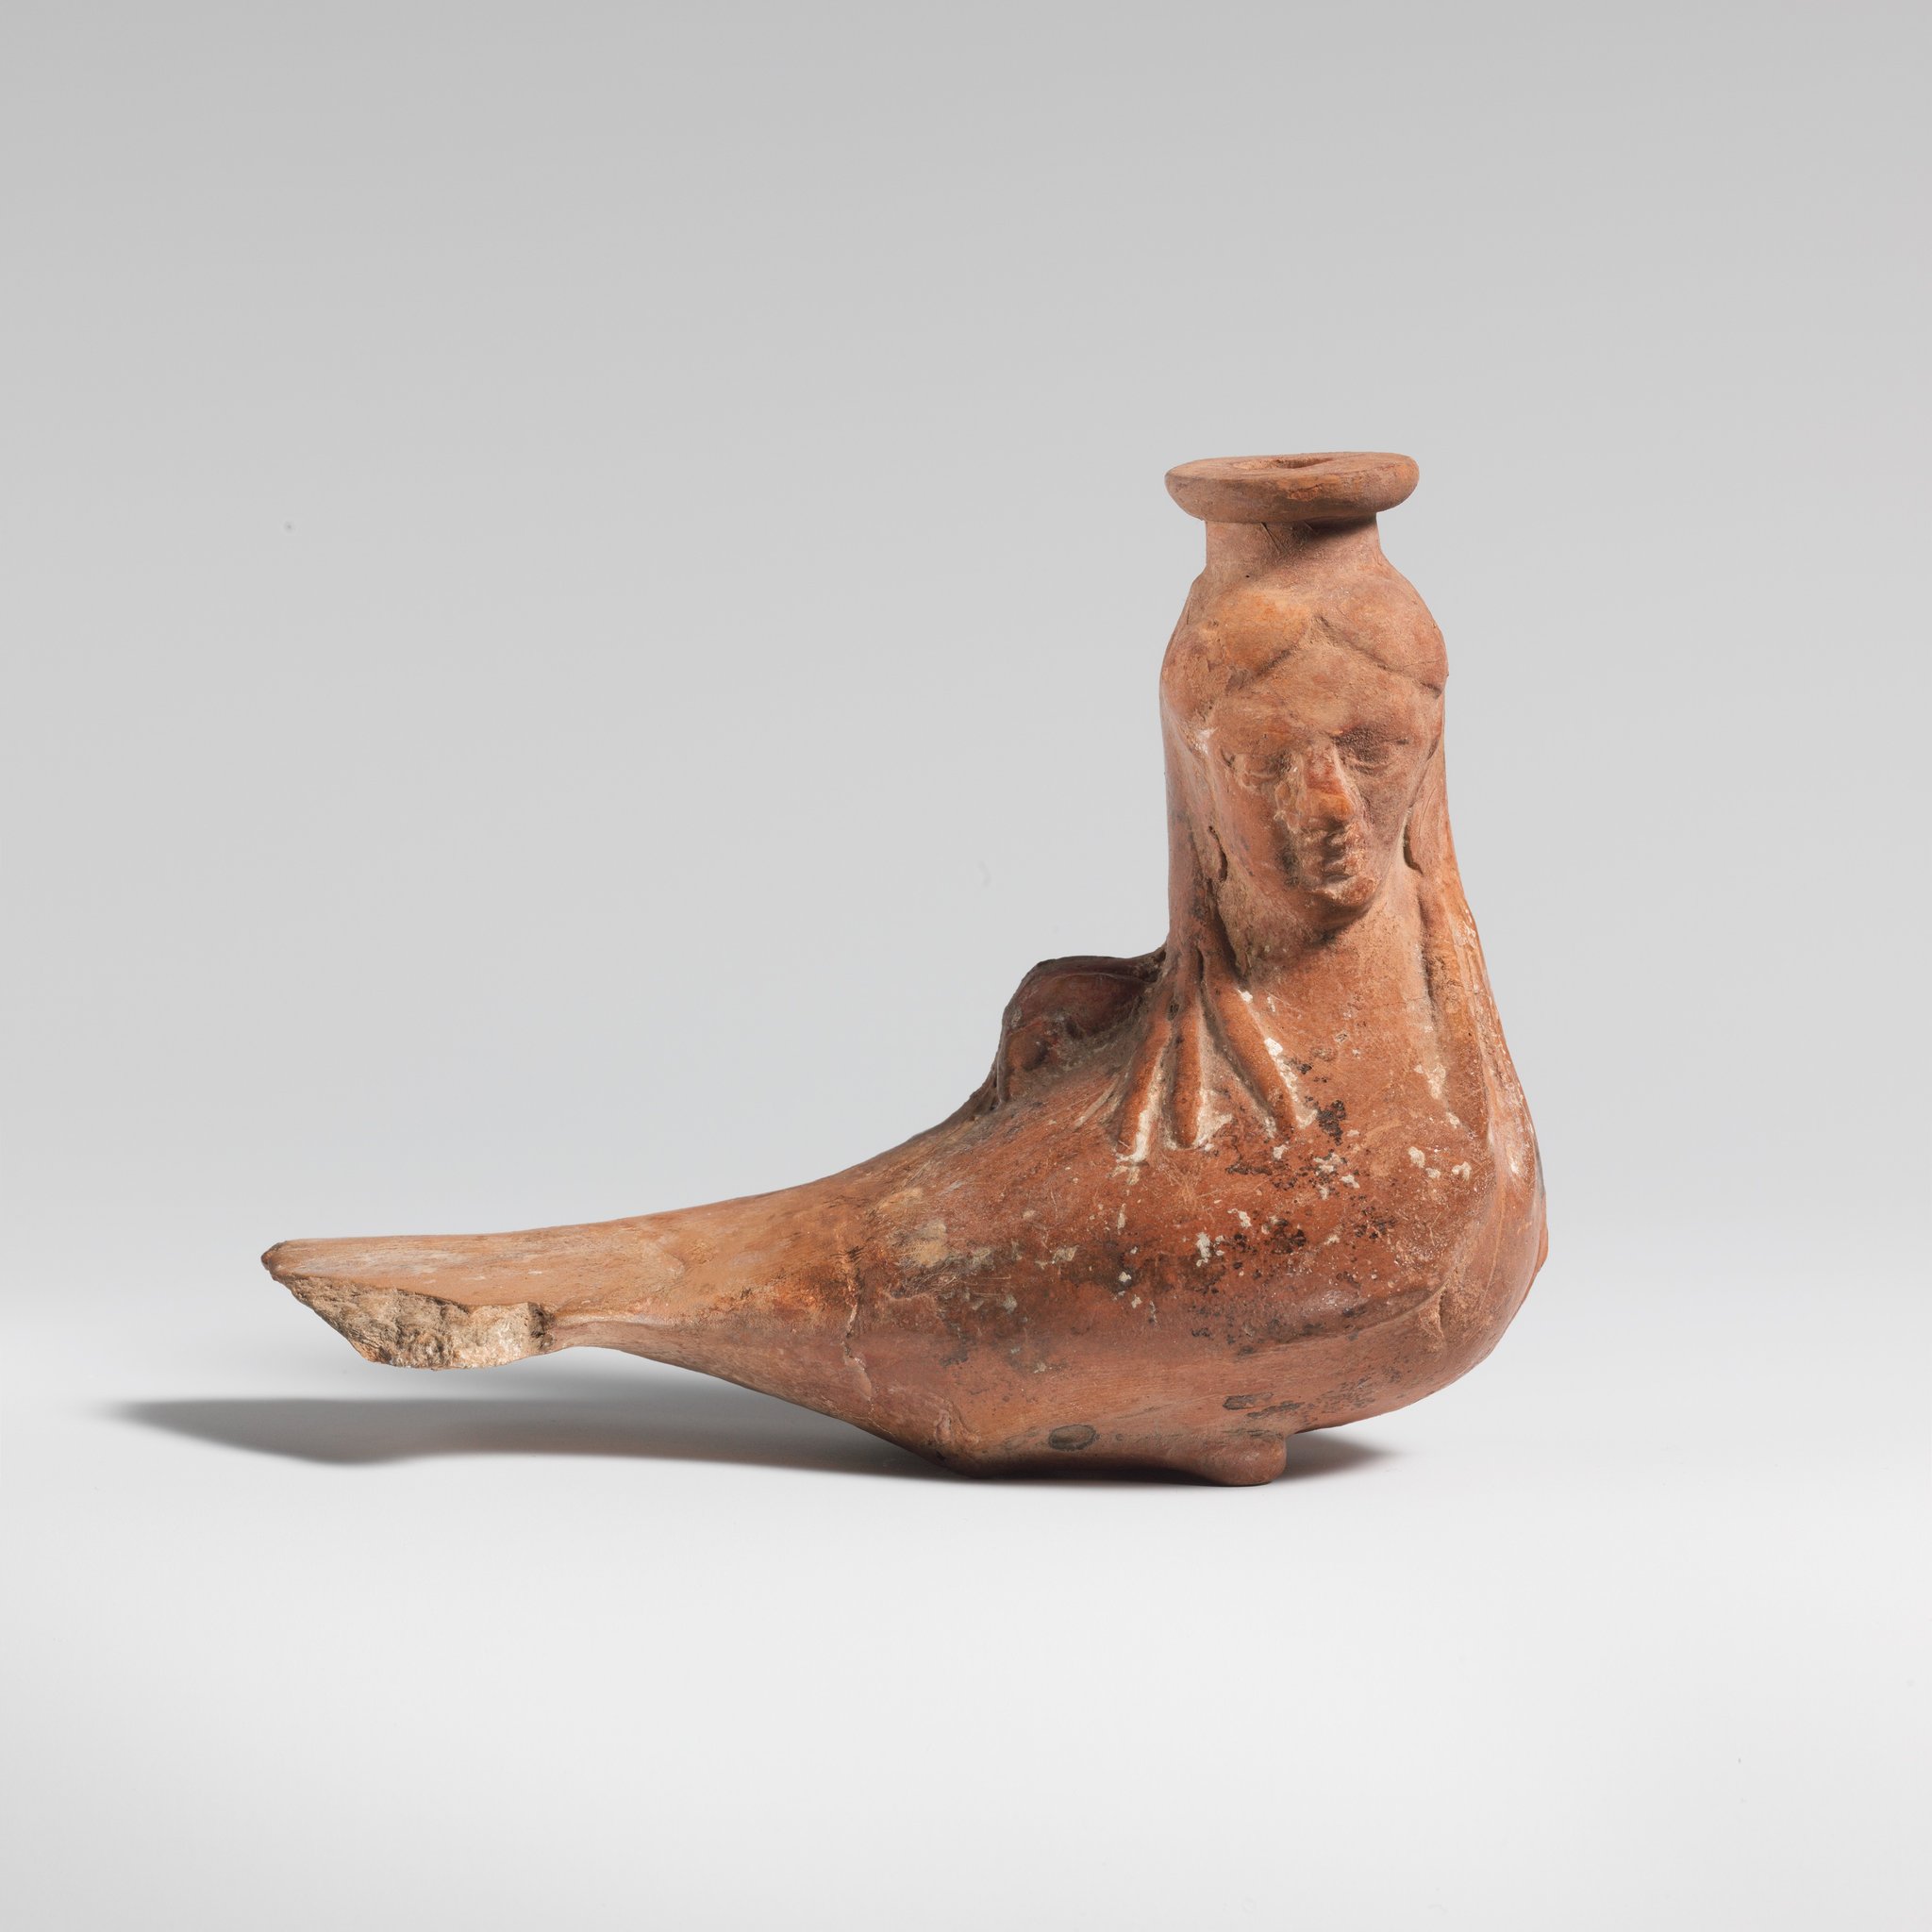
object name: aryballos in the form of a siren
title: Terracotta vase in the form of a siren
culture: east greek, rhodian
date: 550-500 BCE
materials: terracotta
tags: sirens